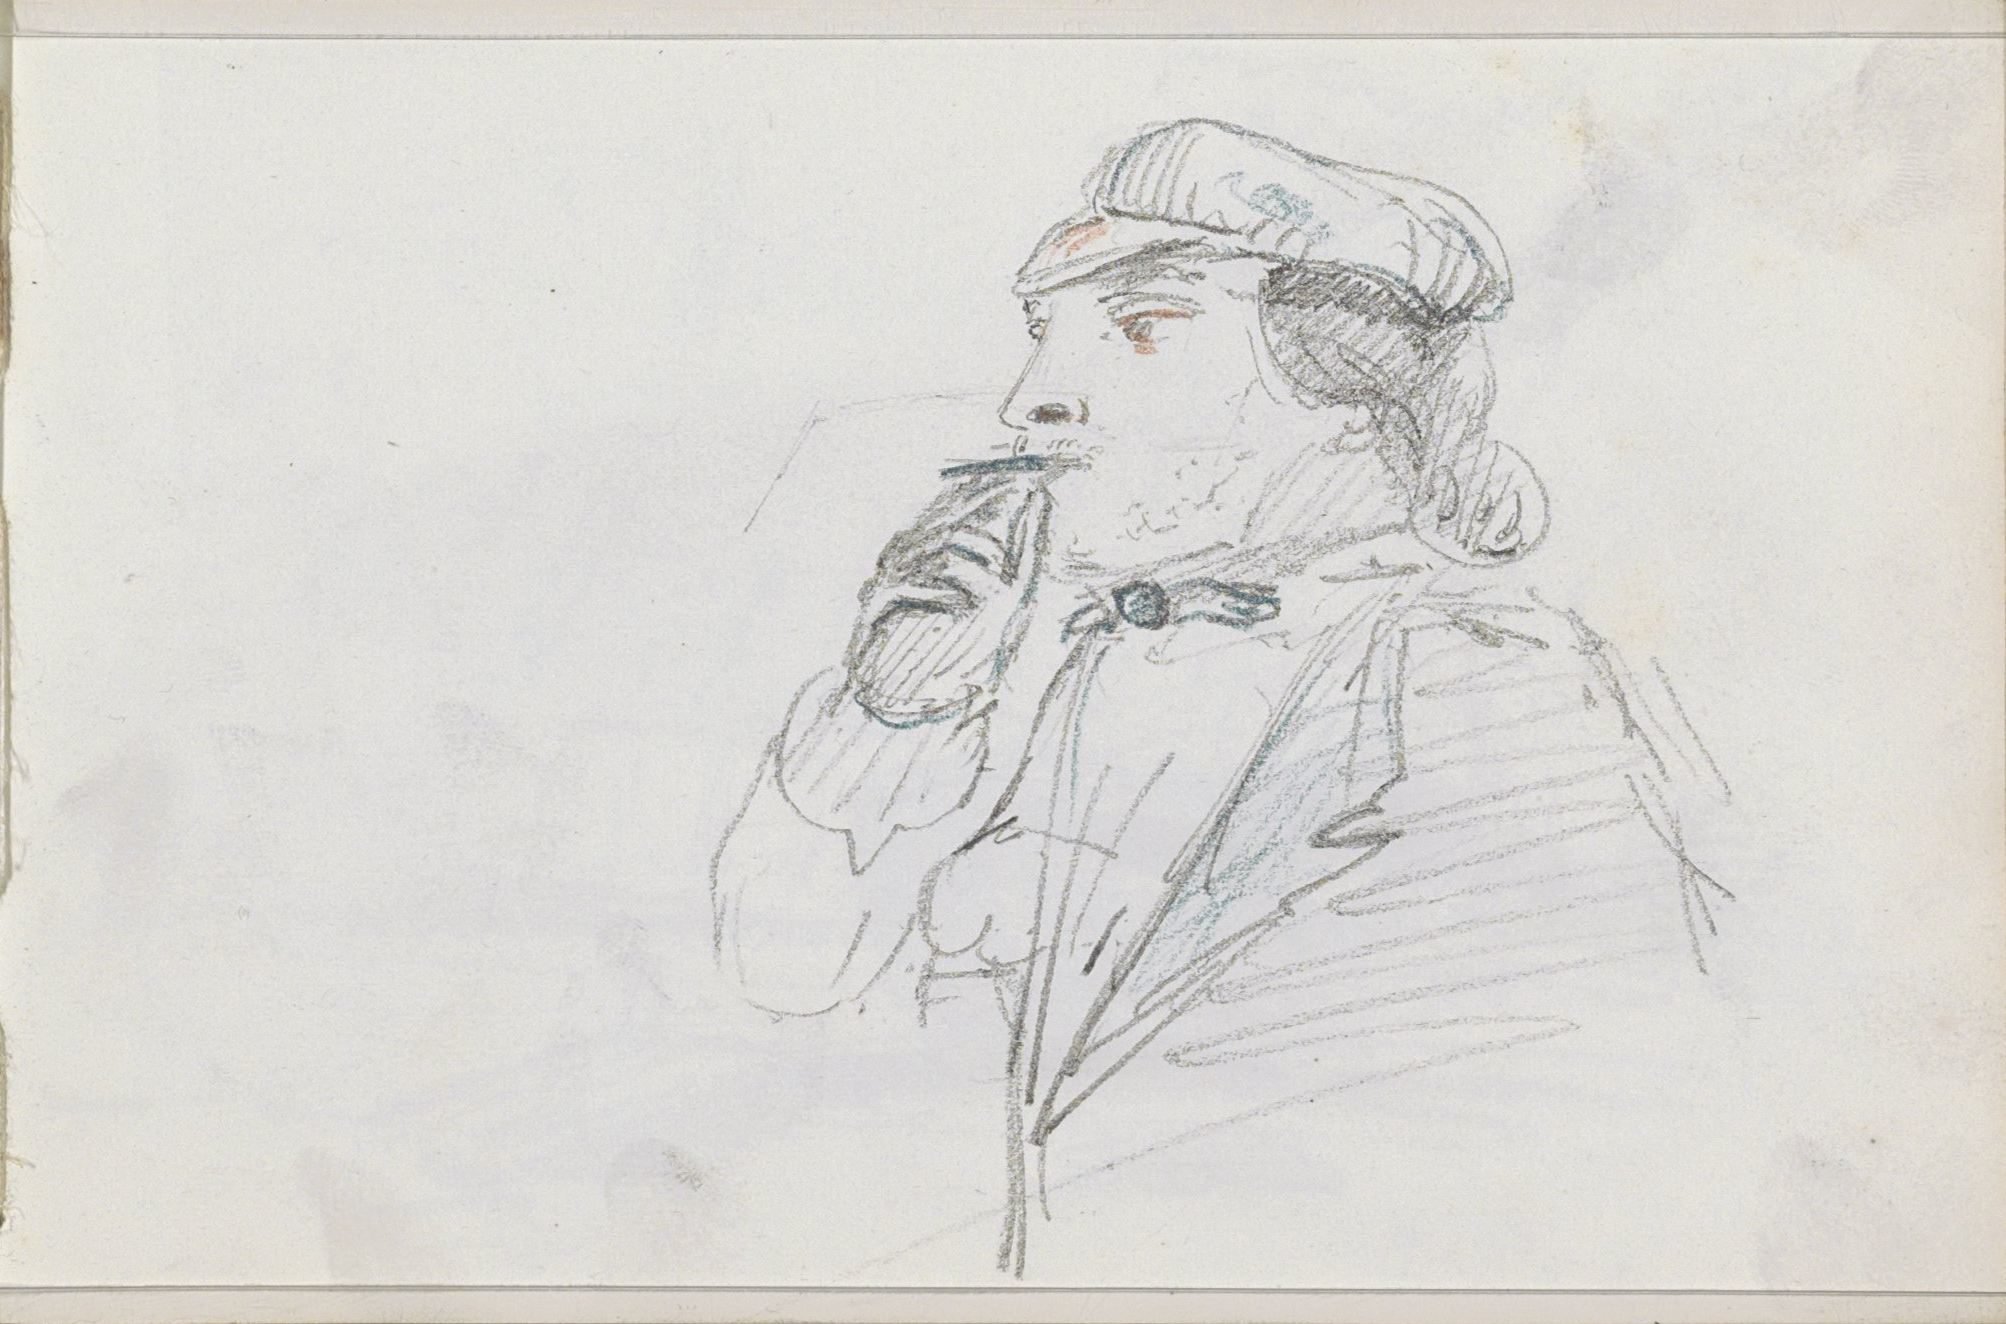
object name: sketchbook leaf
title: Rokende man met een pet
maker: isaac gosschalk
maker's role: draughtsman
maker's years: 1838-1907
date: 1860-1861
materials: chalk, paper, pencil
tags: cigarette, adult man, head-gear: hat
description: De man draagt een das en een jas. Blad 9 recto uit een schetsboek met 29 bladen.